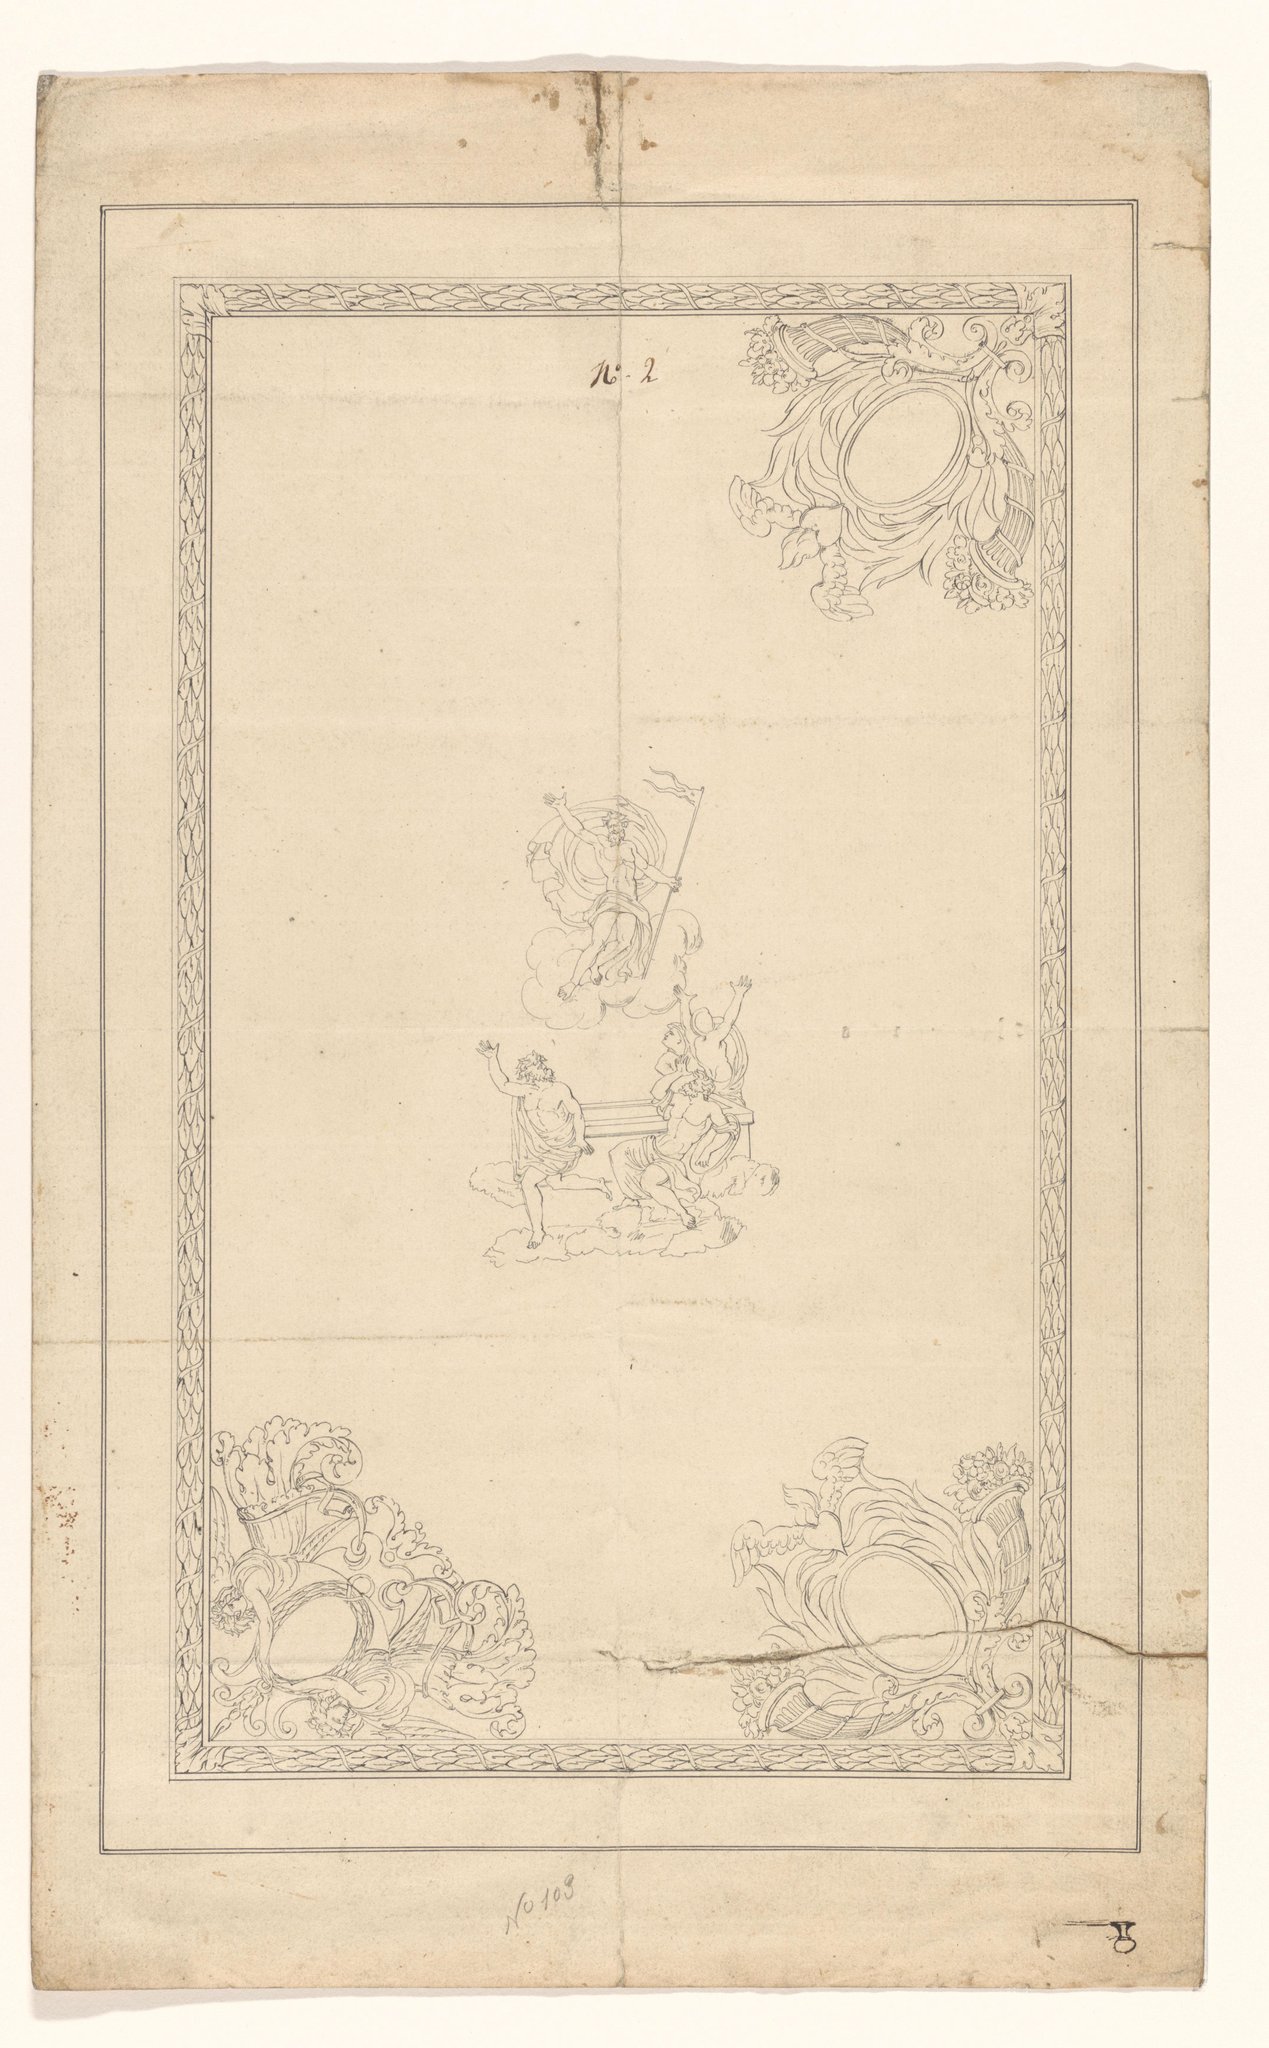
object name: design drawing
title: Ontwerp voor een boekband met in het midden de herrijzenis van Christus en met drie alternatieve hoekvullingen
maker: Anonymous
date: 1800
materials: ink, paper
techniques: pen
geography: paris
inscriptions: inscription: ‘No. 2’, number: ‘No 103’, watermark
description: Rechts onder schets van knopje in pen en bruine inkt.